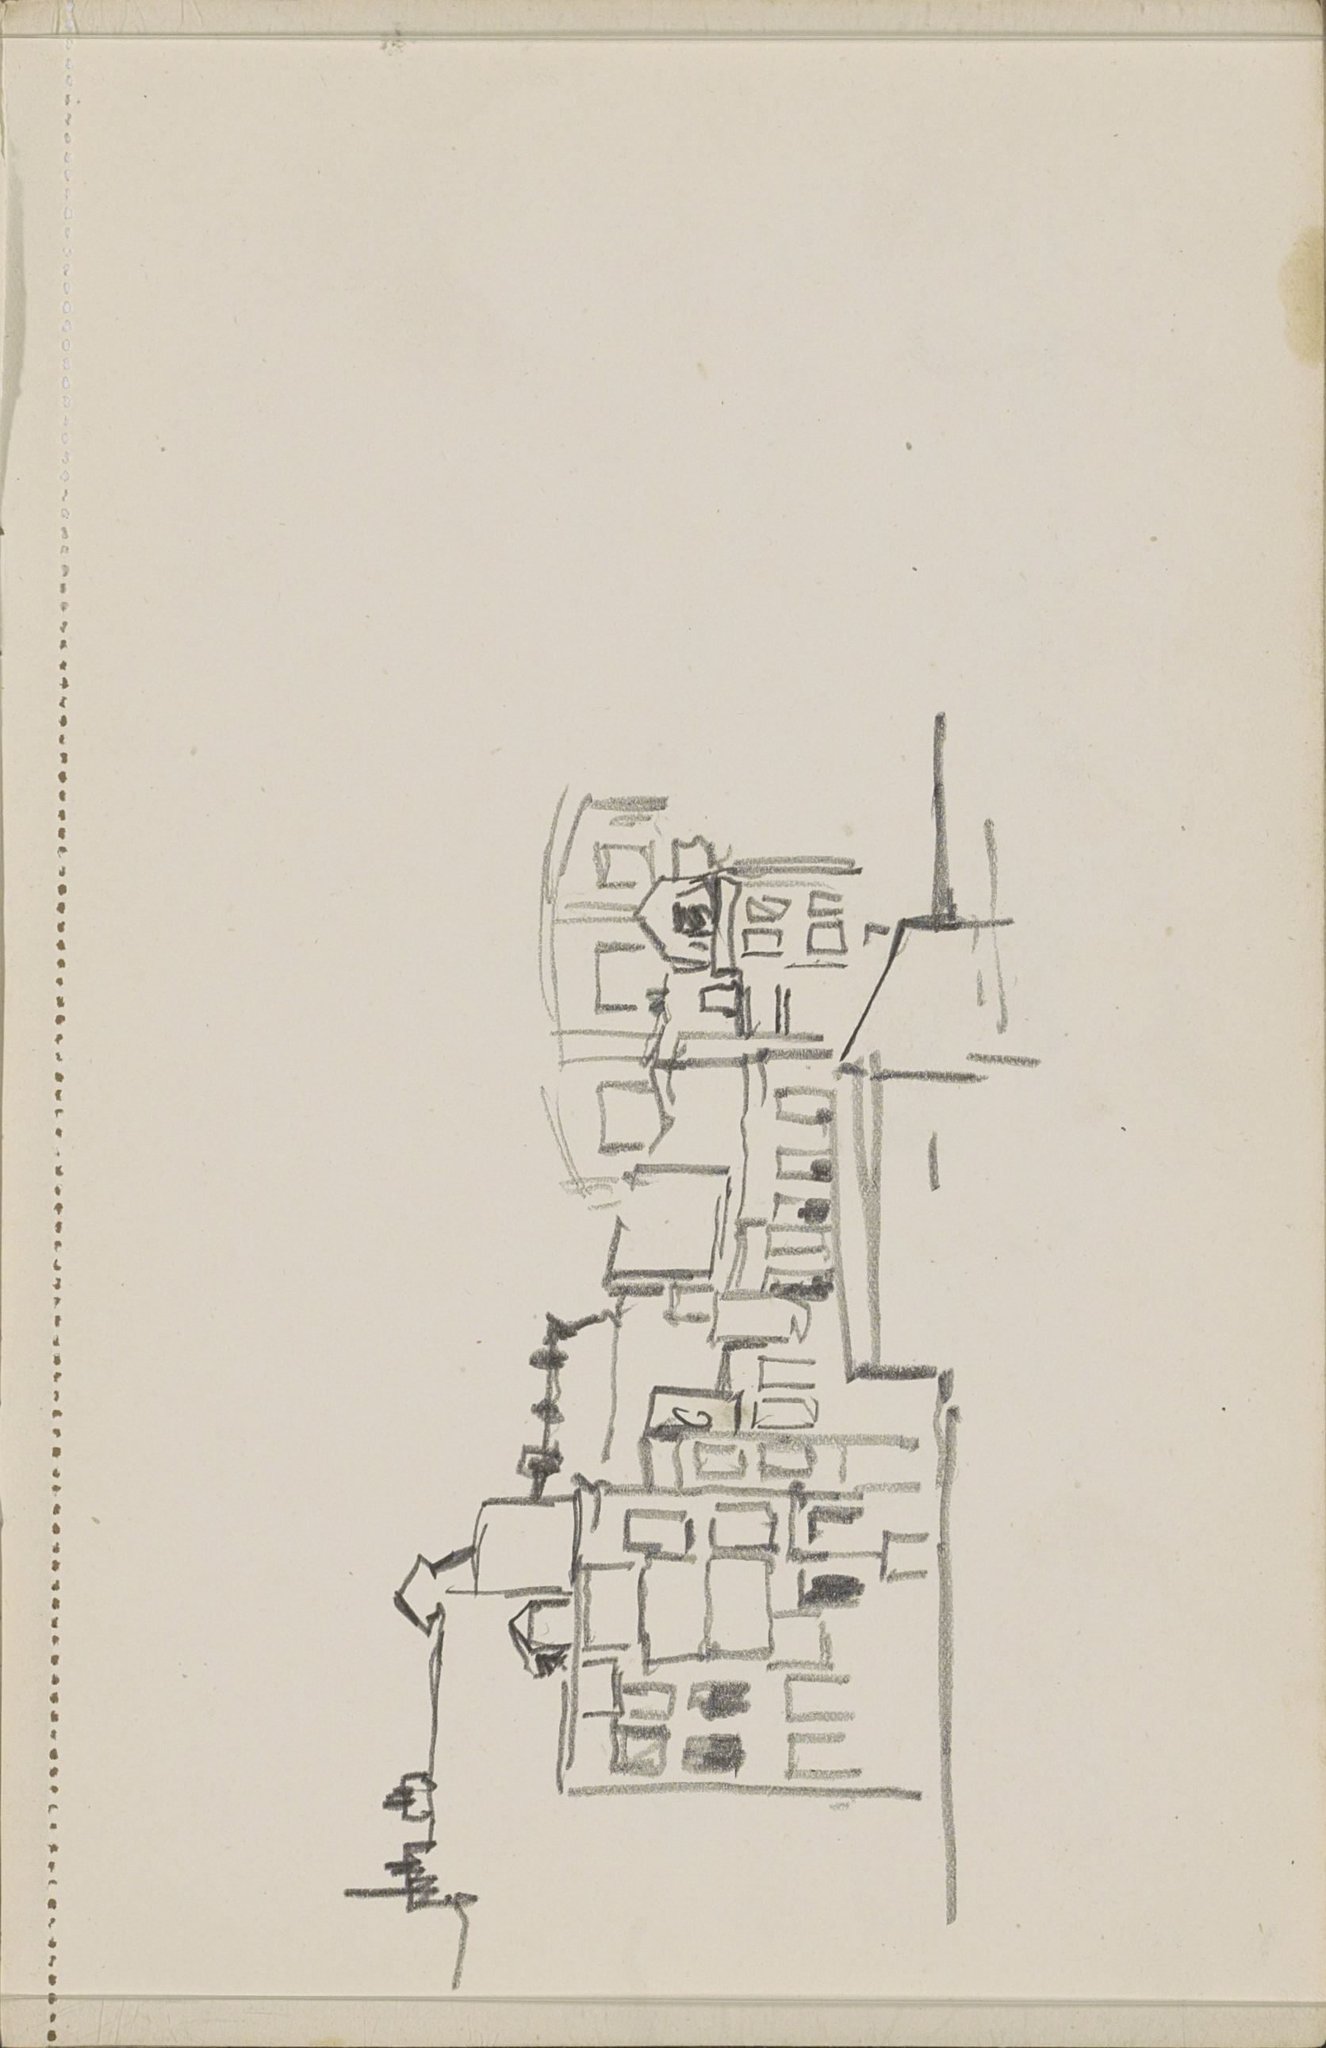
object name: sketchbook leaf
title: Rij huizen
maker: cornelis vreedenburgh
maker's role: draughtsman, print maker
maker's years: 1880-1946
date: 1890-1946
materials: paper, pencil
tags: the usual house or row of houses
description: Blad 19 recto uit een schetsboek met 61 bladen.